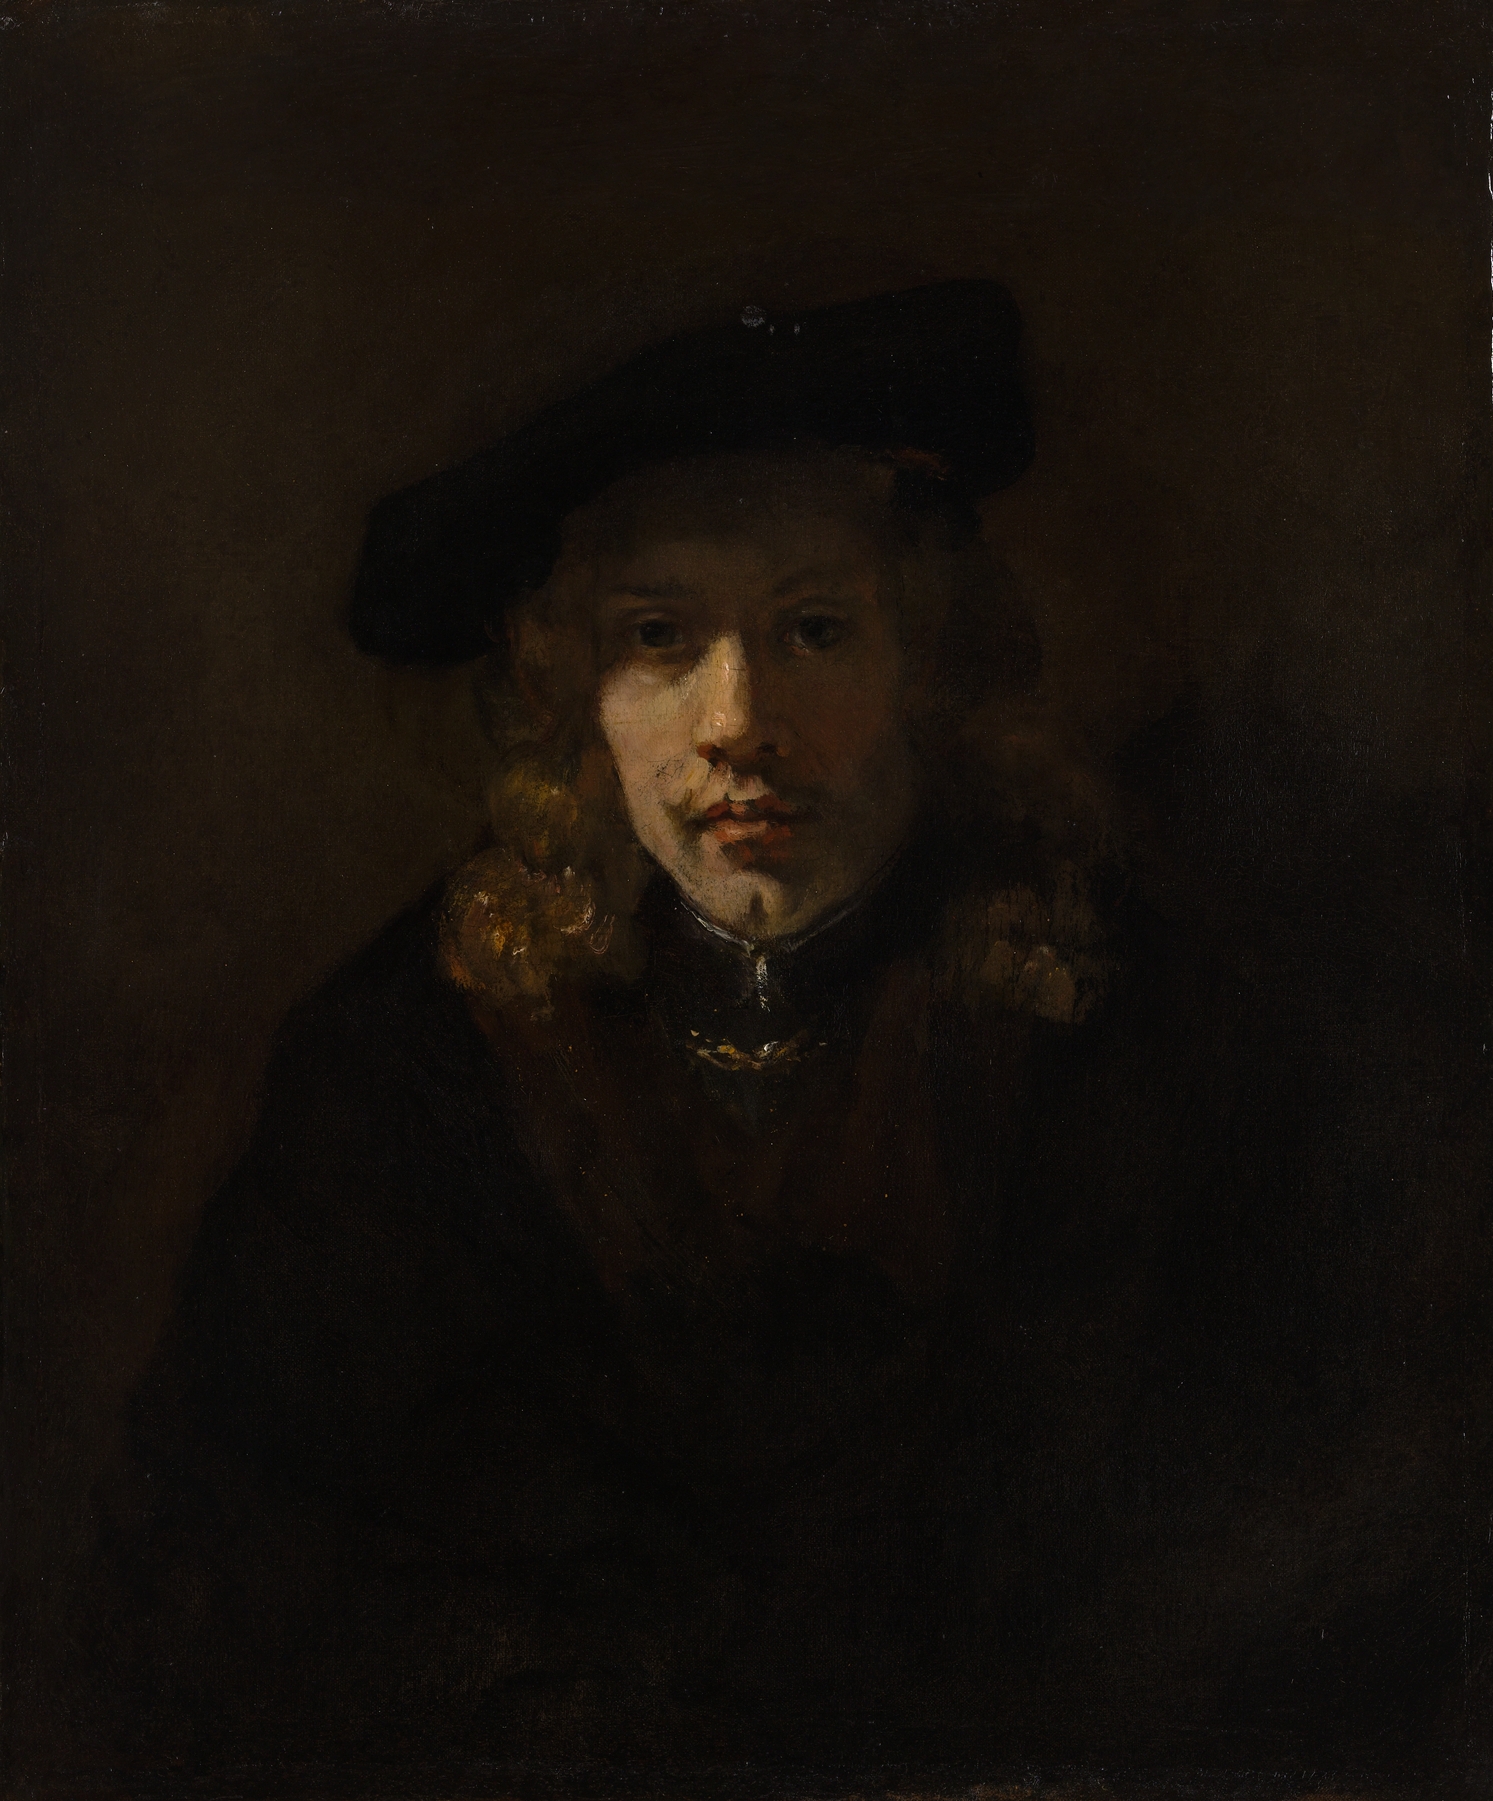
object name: painting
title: Man in a Beret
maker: rembrandt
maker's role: artist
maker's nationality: dutch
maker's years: 1606-1669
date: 1675-1699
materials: canvas, oil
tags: men,portraits